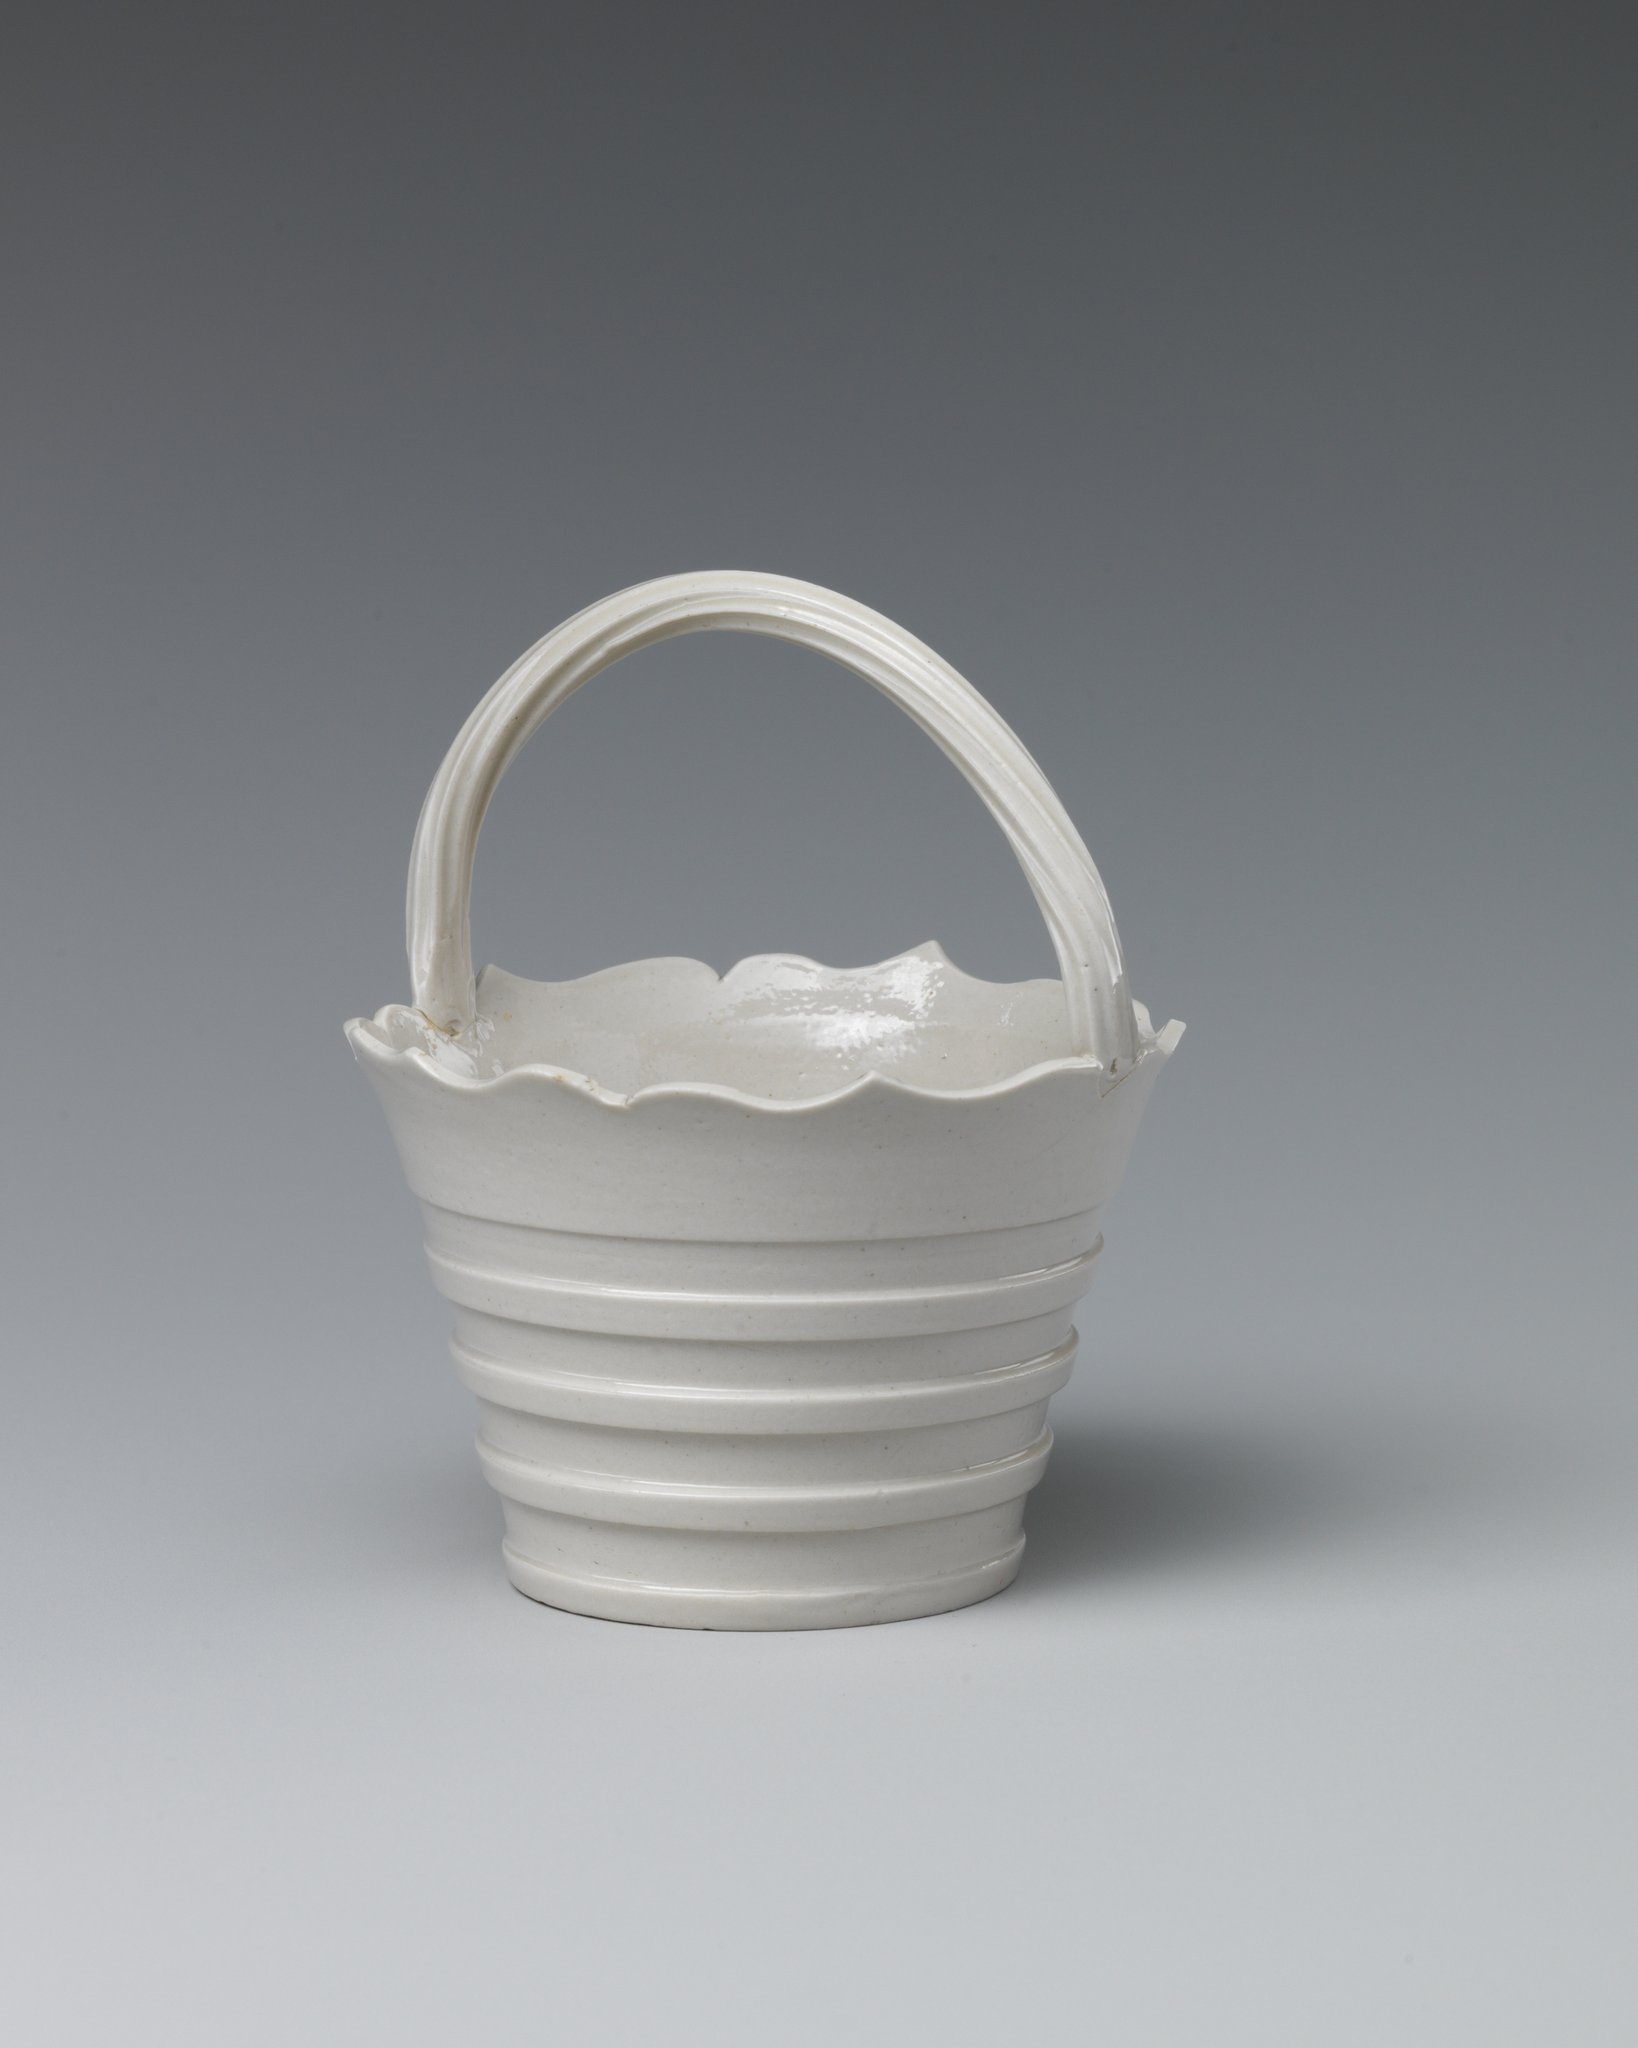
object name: pail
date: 1740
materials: stoneware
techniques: salt glaze